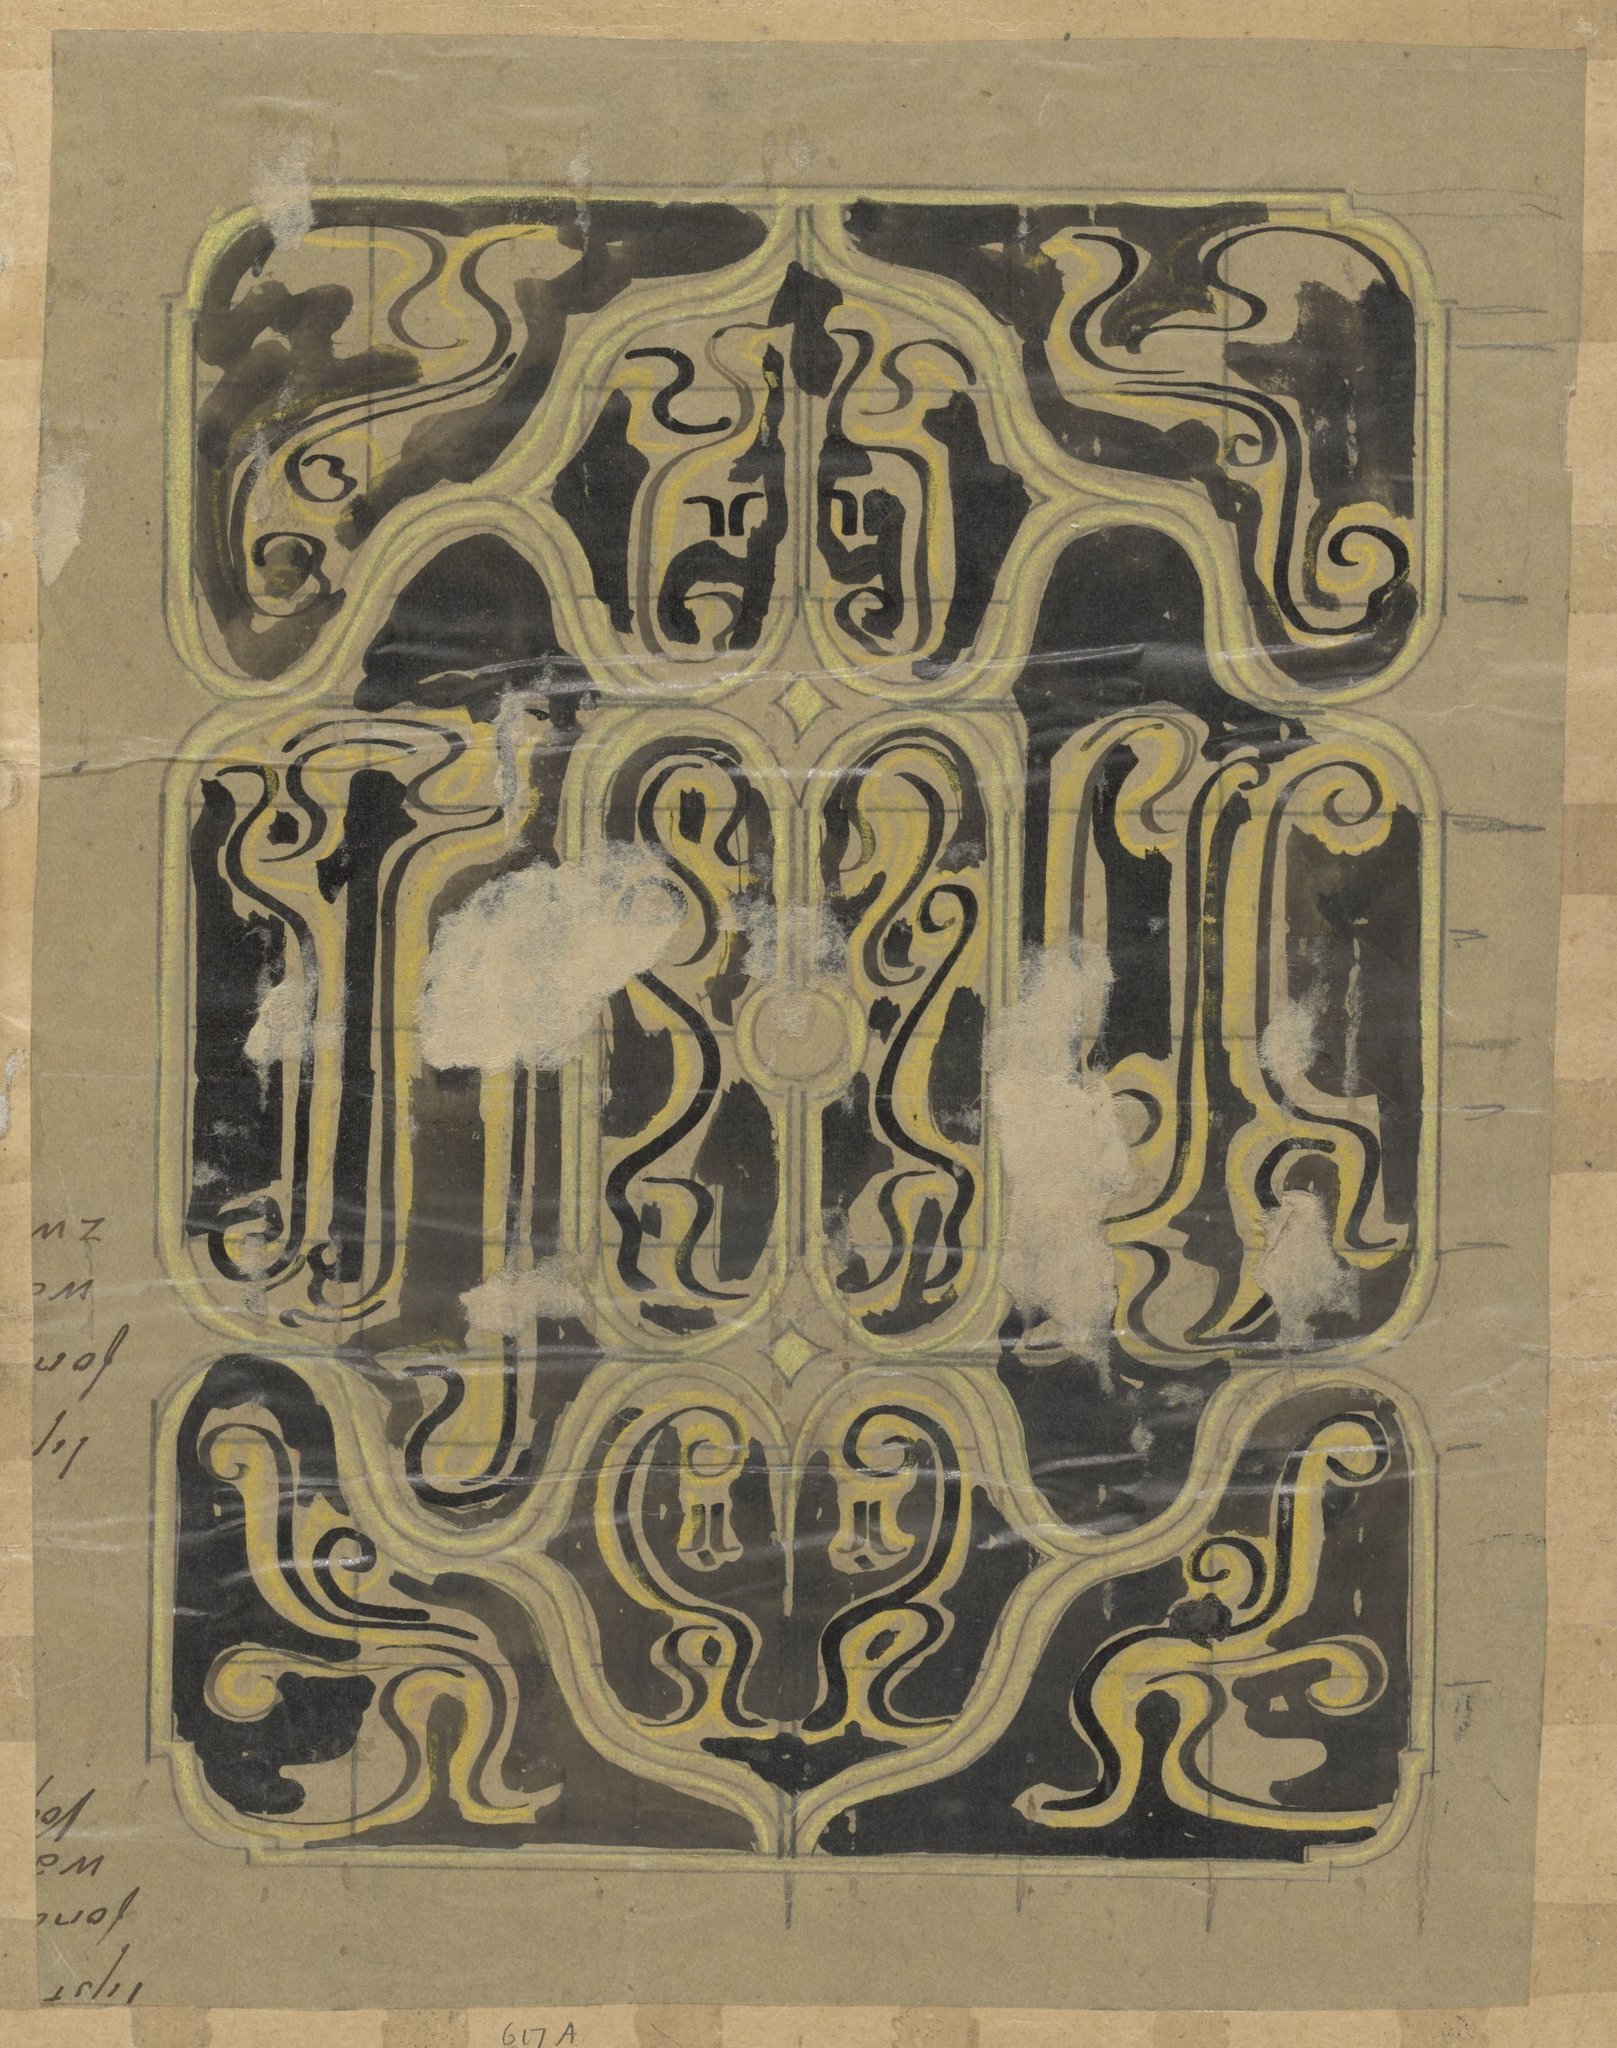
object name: drawing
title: Decoratief ontwerp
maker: carel adolph lion cachet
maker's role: draughtsman, print maker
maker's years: 1864-1945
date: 1874-1945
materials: chalk, paper, pencil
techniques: brush